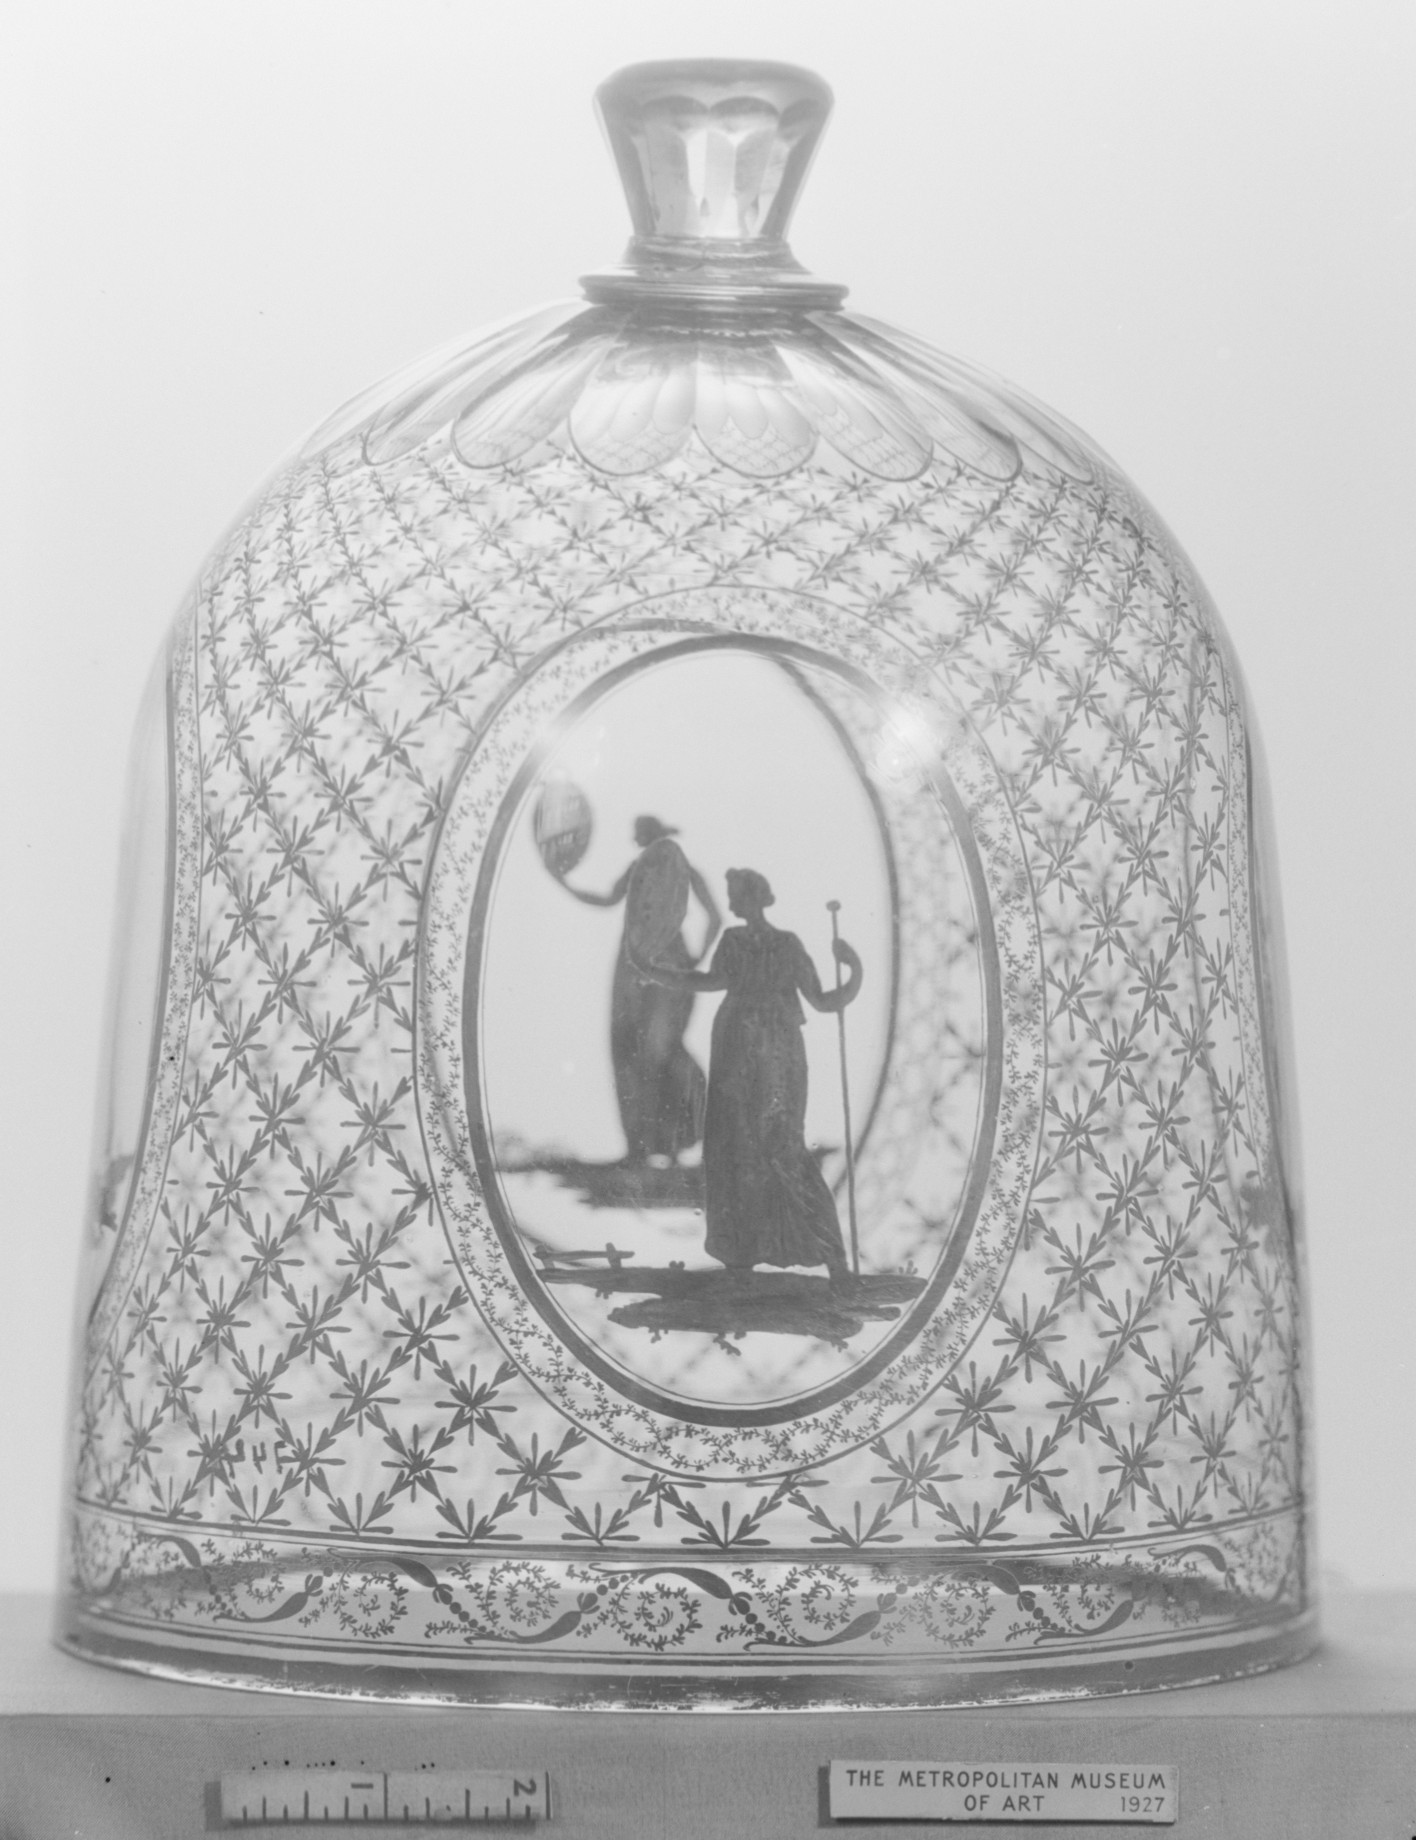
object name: bell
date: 1775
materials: glass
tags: human figures,musical instruments